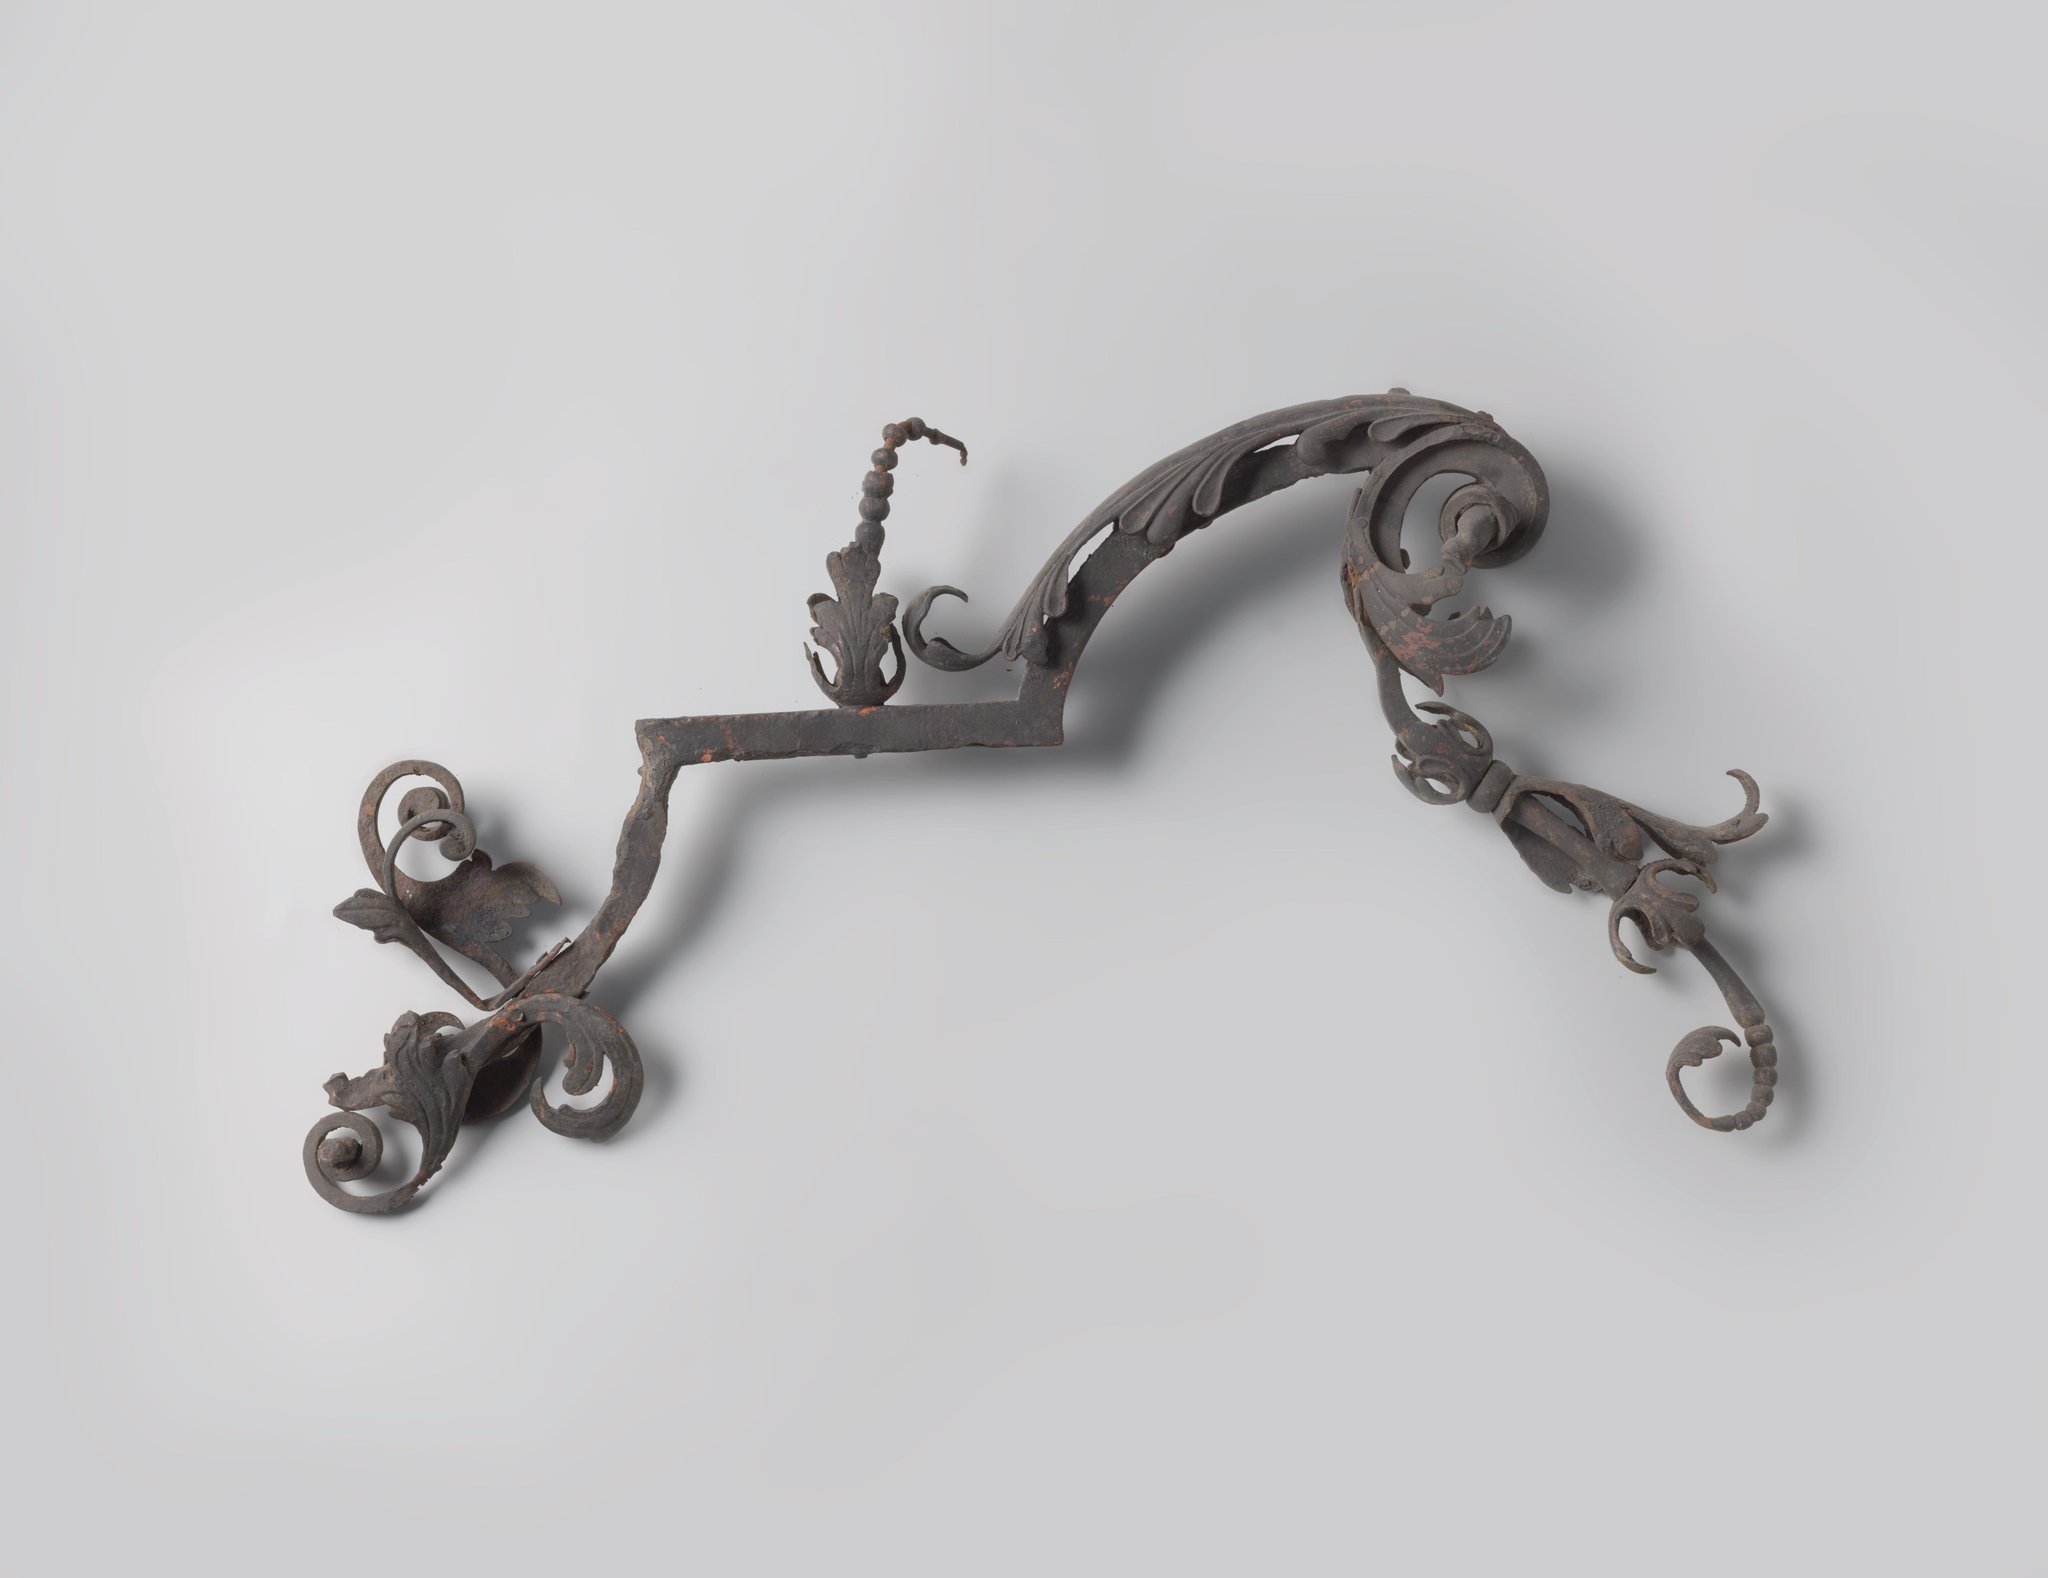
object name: uithangteken, uithangbord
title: Ornament met acanthusbladeren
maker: Anonymous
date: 1700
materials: iron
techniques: forging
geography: amsterdam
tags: amsterdam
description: Ornament met acanthusbladeren. Onderdeel van een uithangteken van een smederij in de Beulingstraat te Amsterdam.